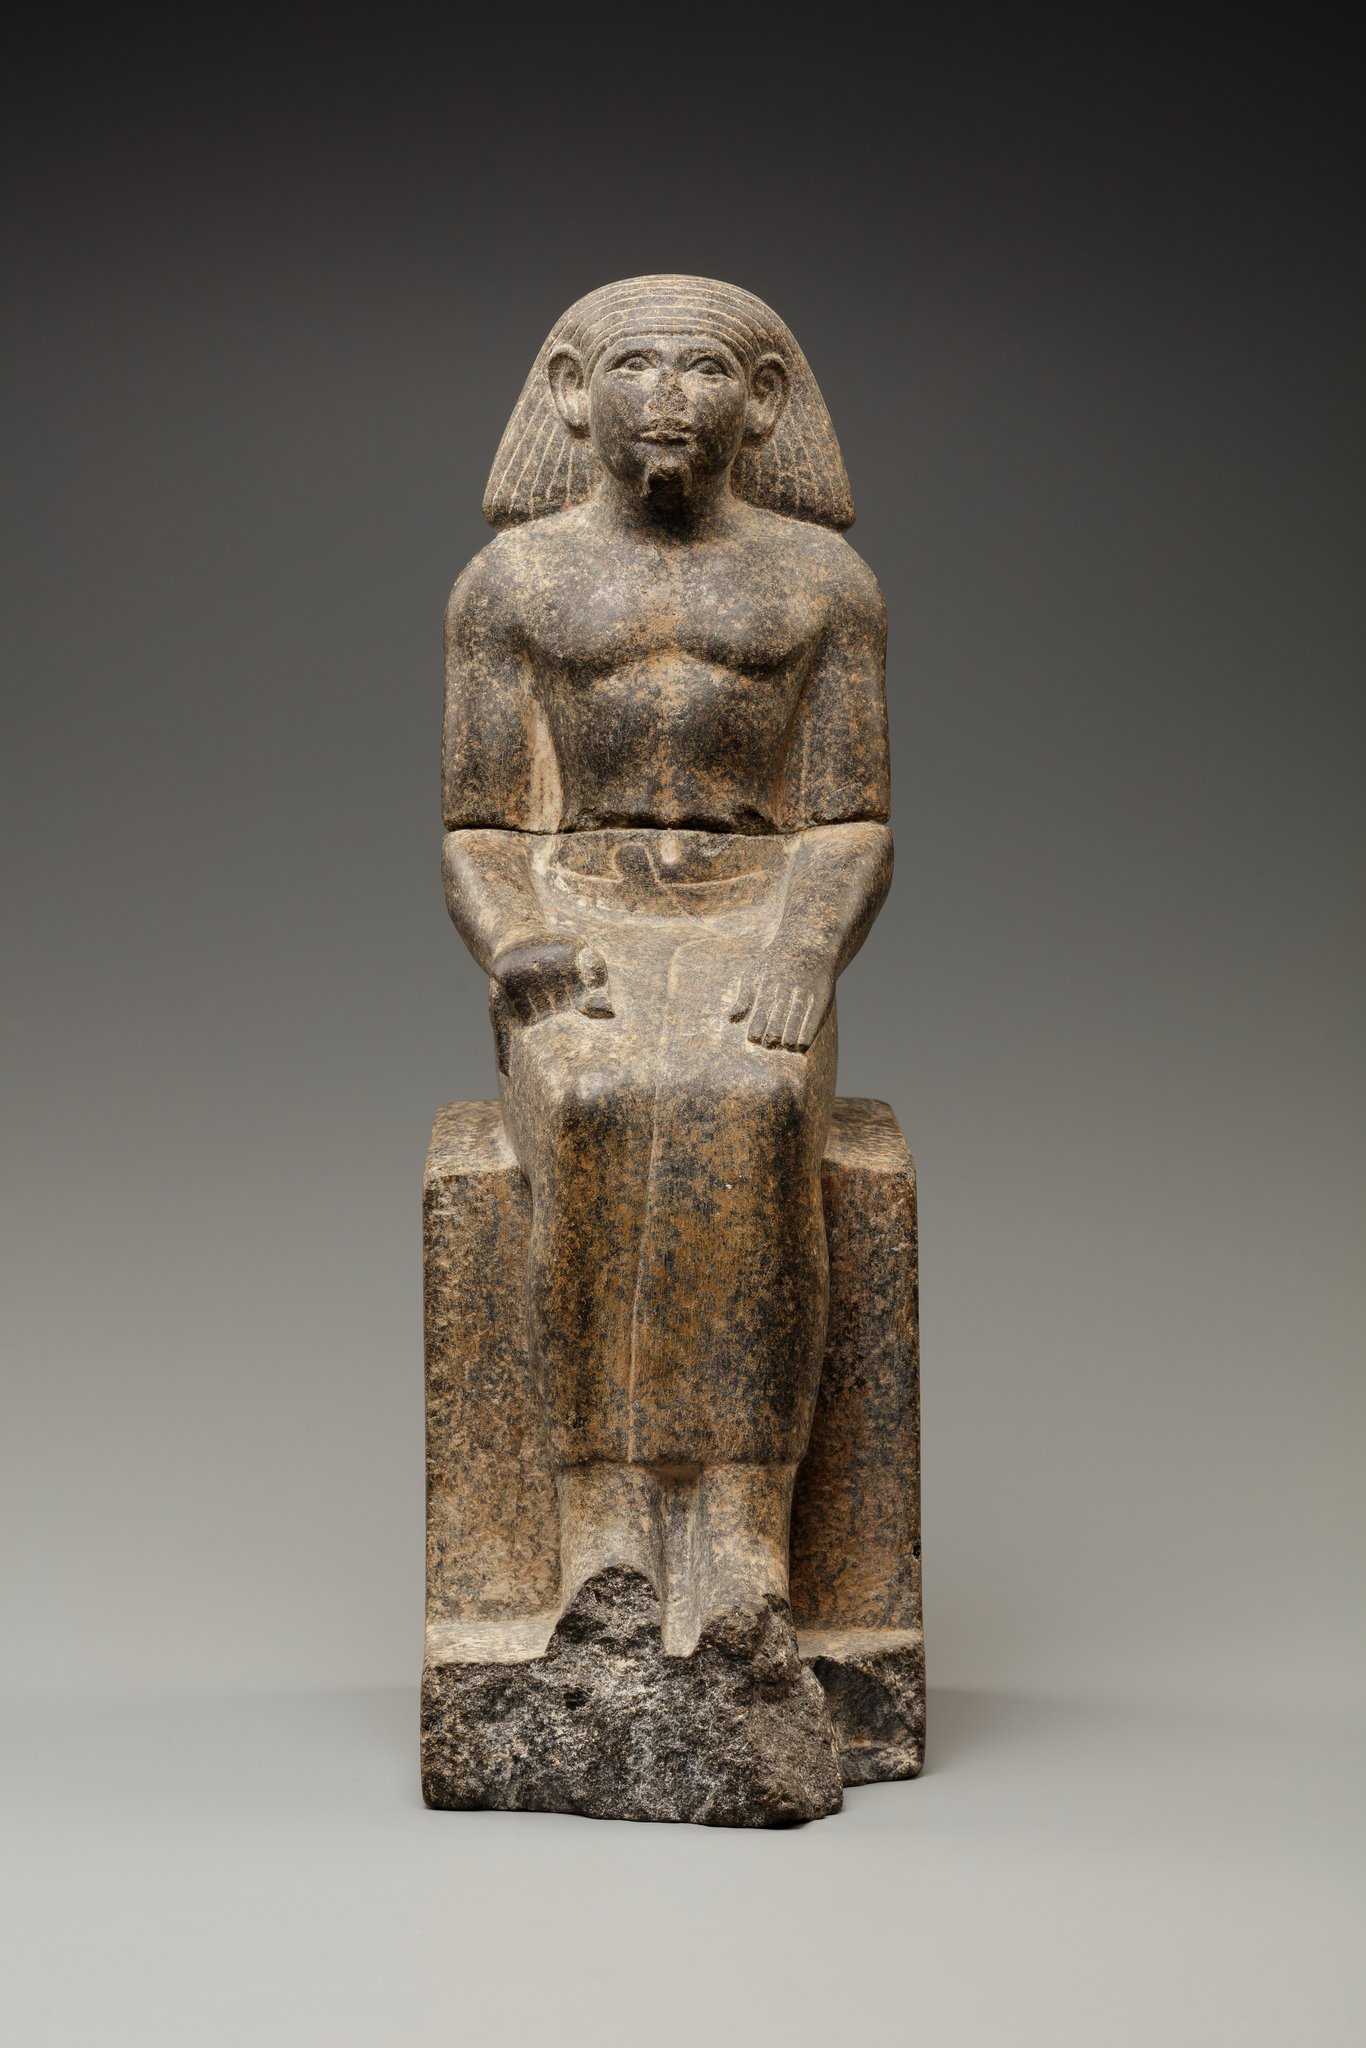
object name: seated statue of kay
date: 1950-1640 BCE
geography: egypt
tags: men